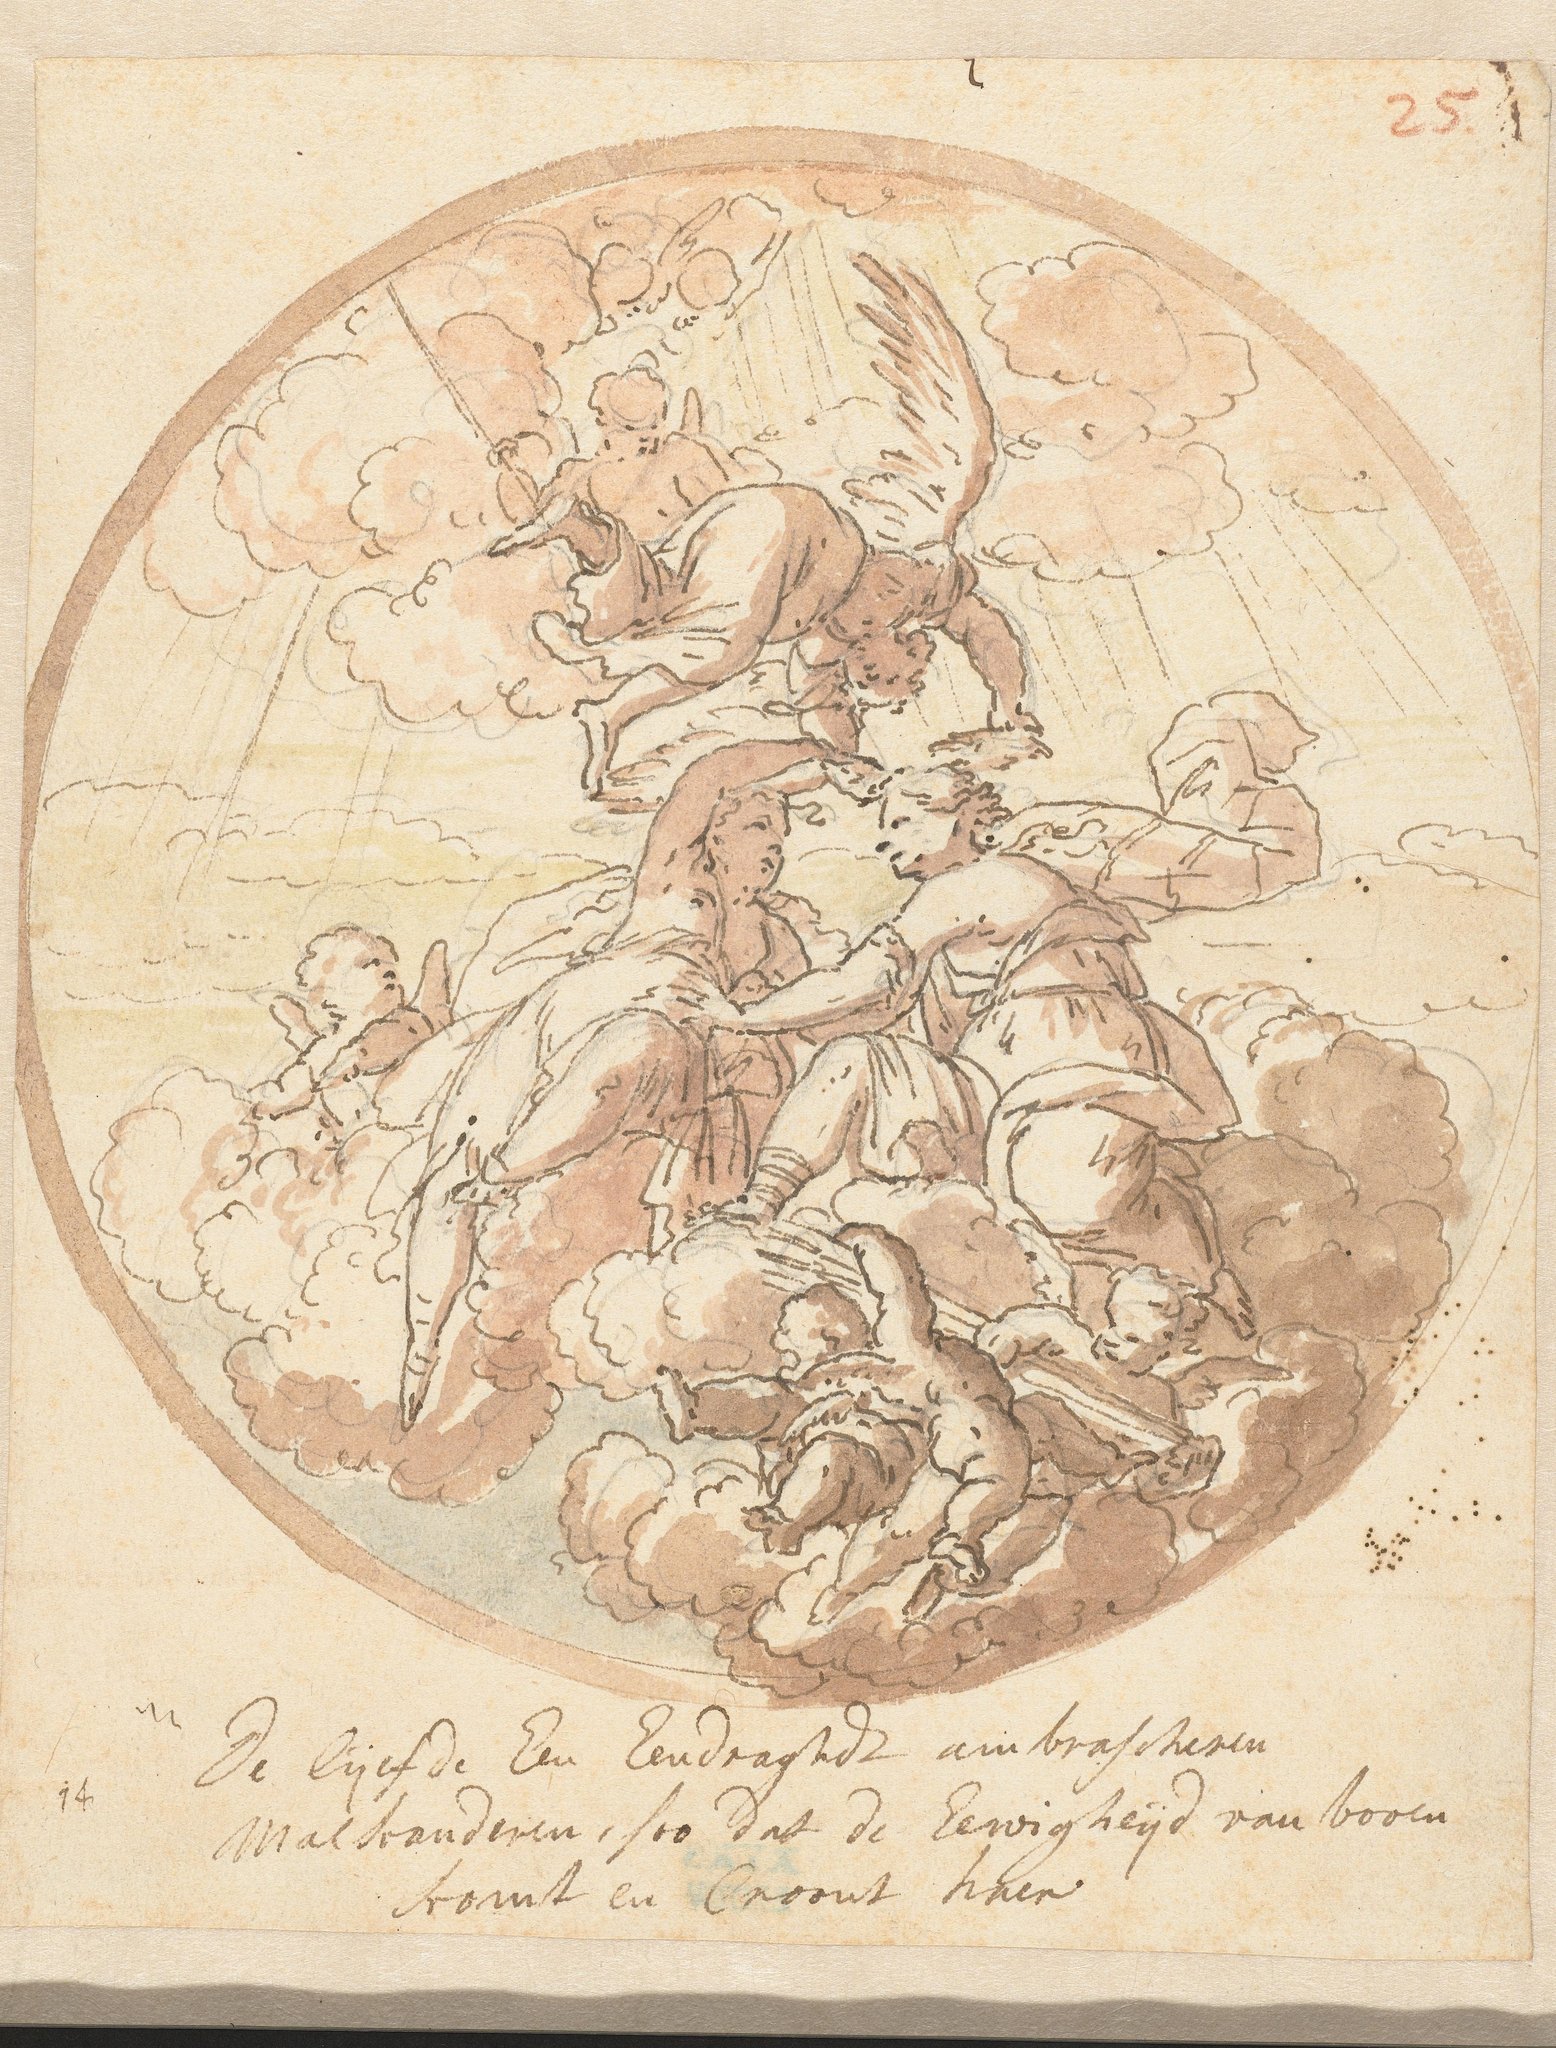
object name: drawing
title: De Liefde en de Eendracht omhelzen elkaar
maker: mattheus terwesten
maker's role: draughtsman, painter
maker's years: 1670-1757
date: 1680-1757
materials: graphite, ink, paper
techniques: brush, pen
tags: agreement, unity; 'concordia', 'concordia insuperabile', 'concordia militare', 'concordia di pace', 'unione civile' (ripa), embracing each other, kissing, (personifications and symbolic representations of) love; 'amore (secondo seneca)' (ripa), eternity, 'aeternitas'; 'eternità','eternità o perpetuità' (ripa), crowning with laurel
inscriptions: : ‘De lijefde een Eendraght ambrasscheren malkanderen, soo dat de Eewigheijd van boven komt en croont haer.’